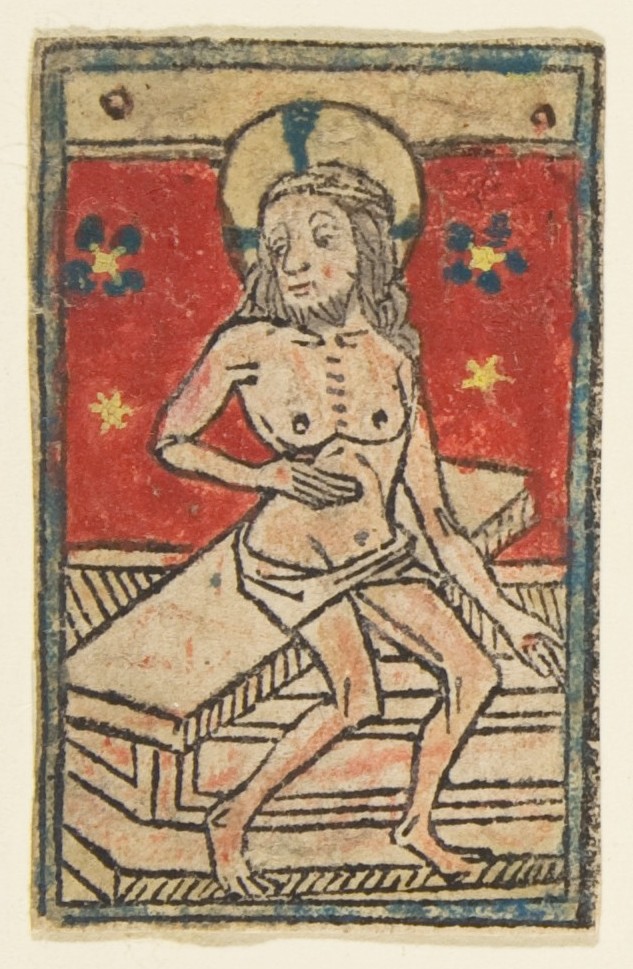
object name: print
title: Seated Man of Sorrows (Schr. 910)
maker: anonymous, german, 15th century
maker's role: artist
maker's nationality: german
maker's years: 1400-1500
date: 1401-1500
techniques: hand coloring, woodcut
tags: christ